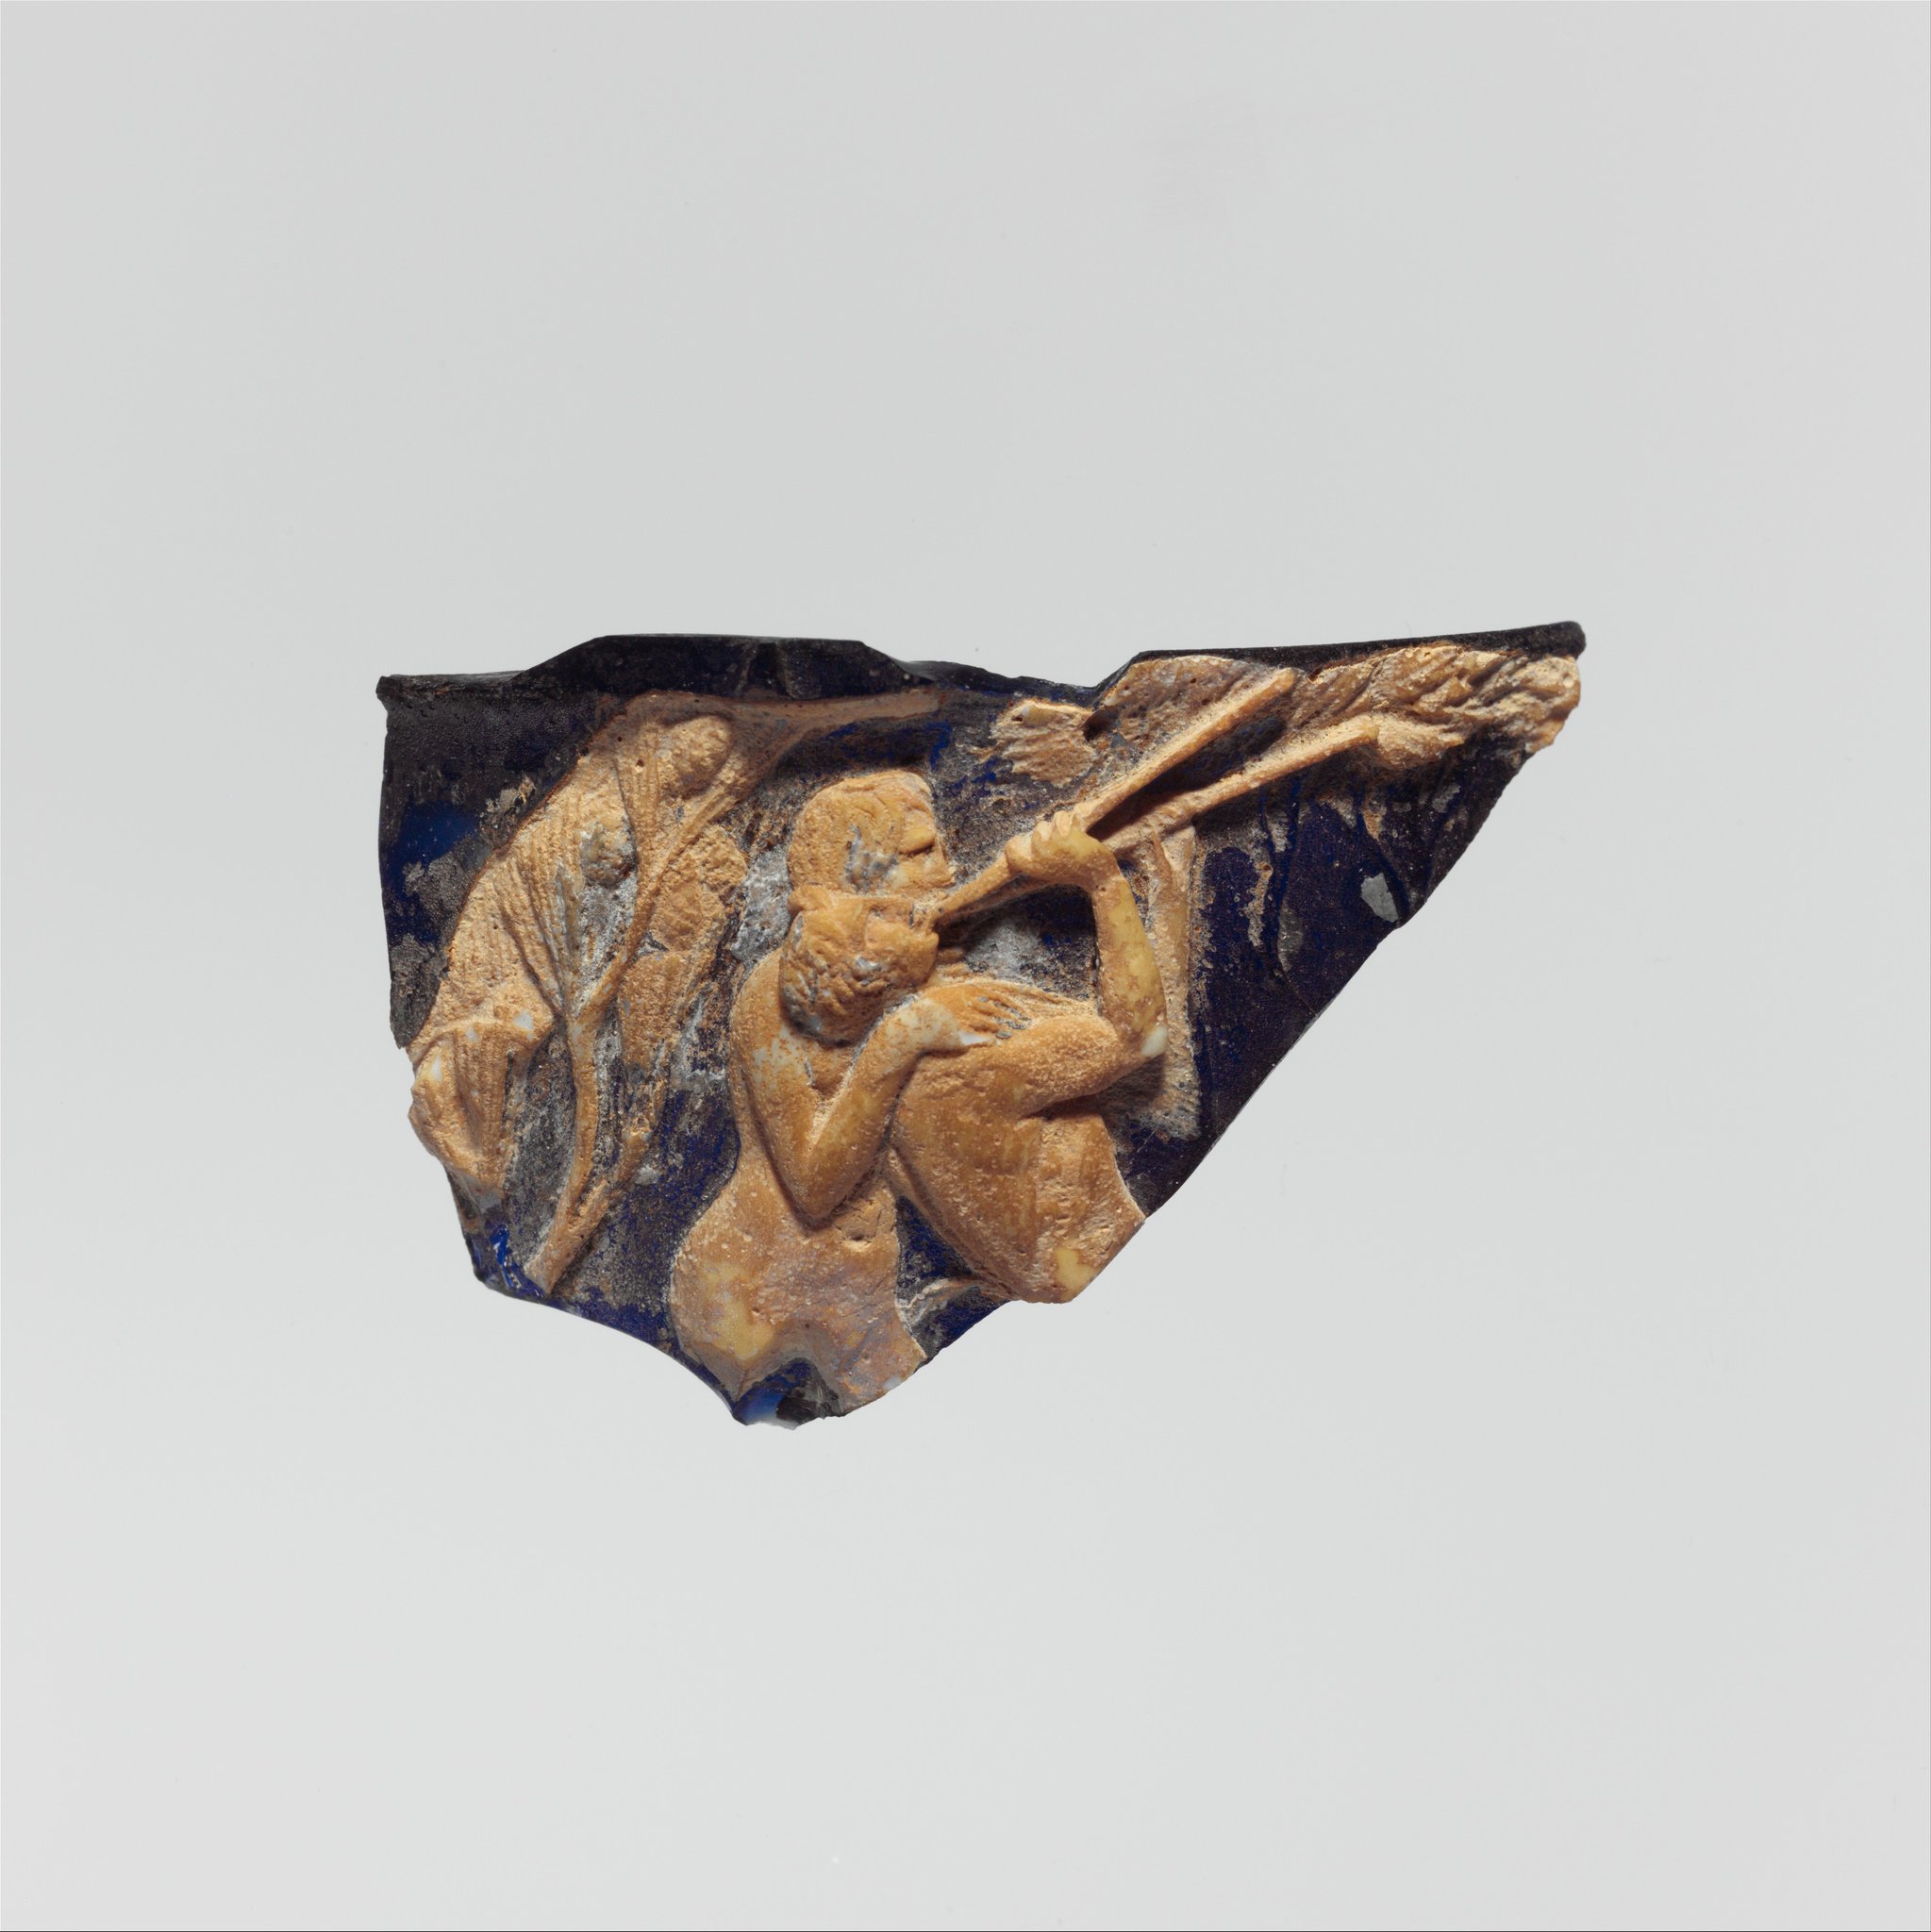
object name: cameo, cup fragment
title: Glass cameo cup (scyphus) fragment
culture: roman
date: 67-100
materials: glass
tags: flutes,satyrs